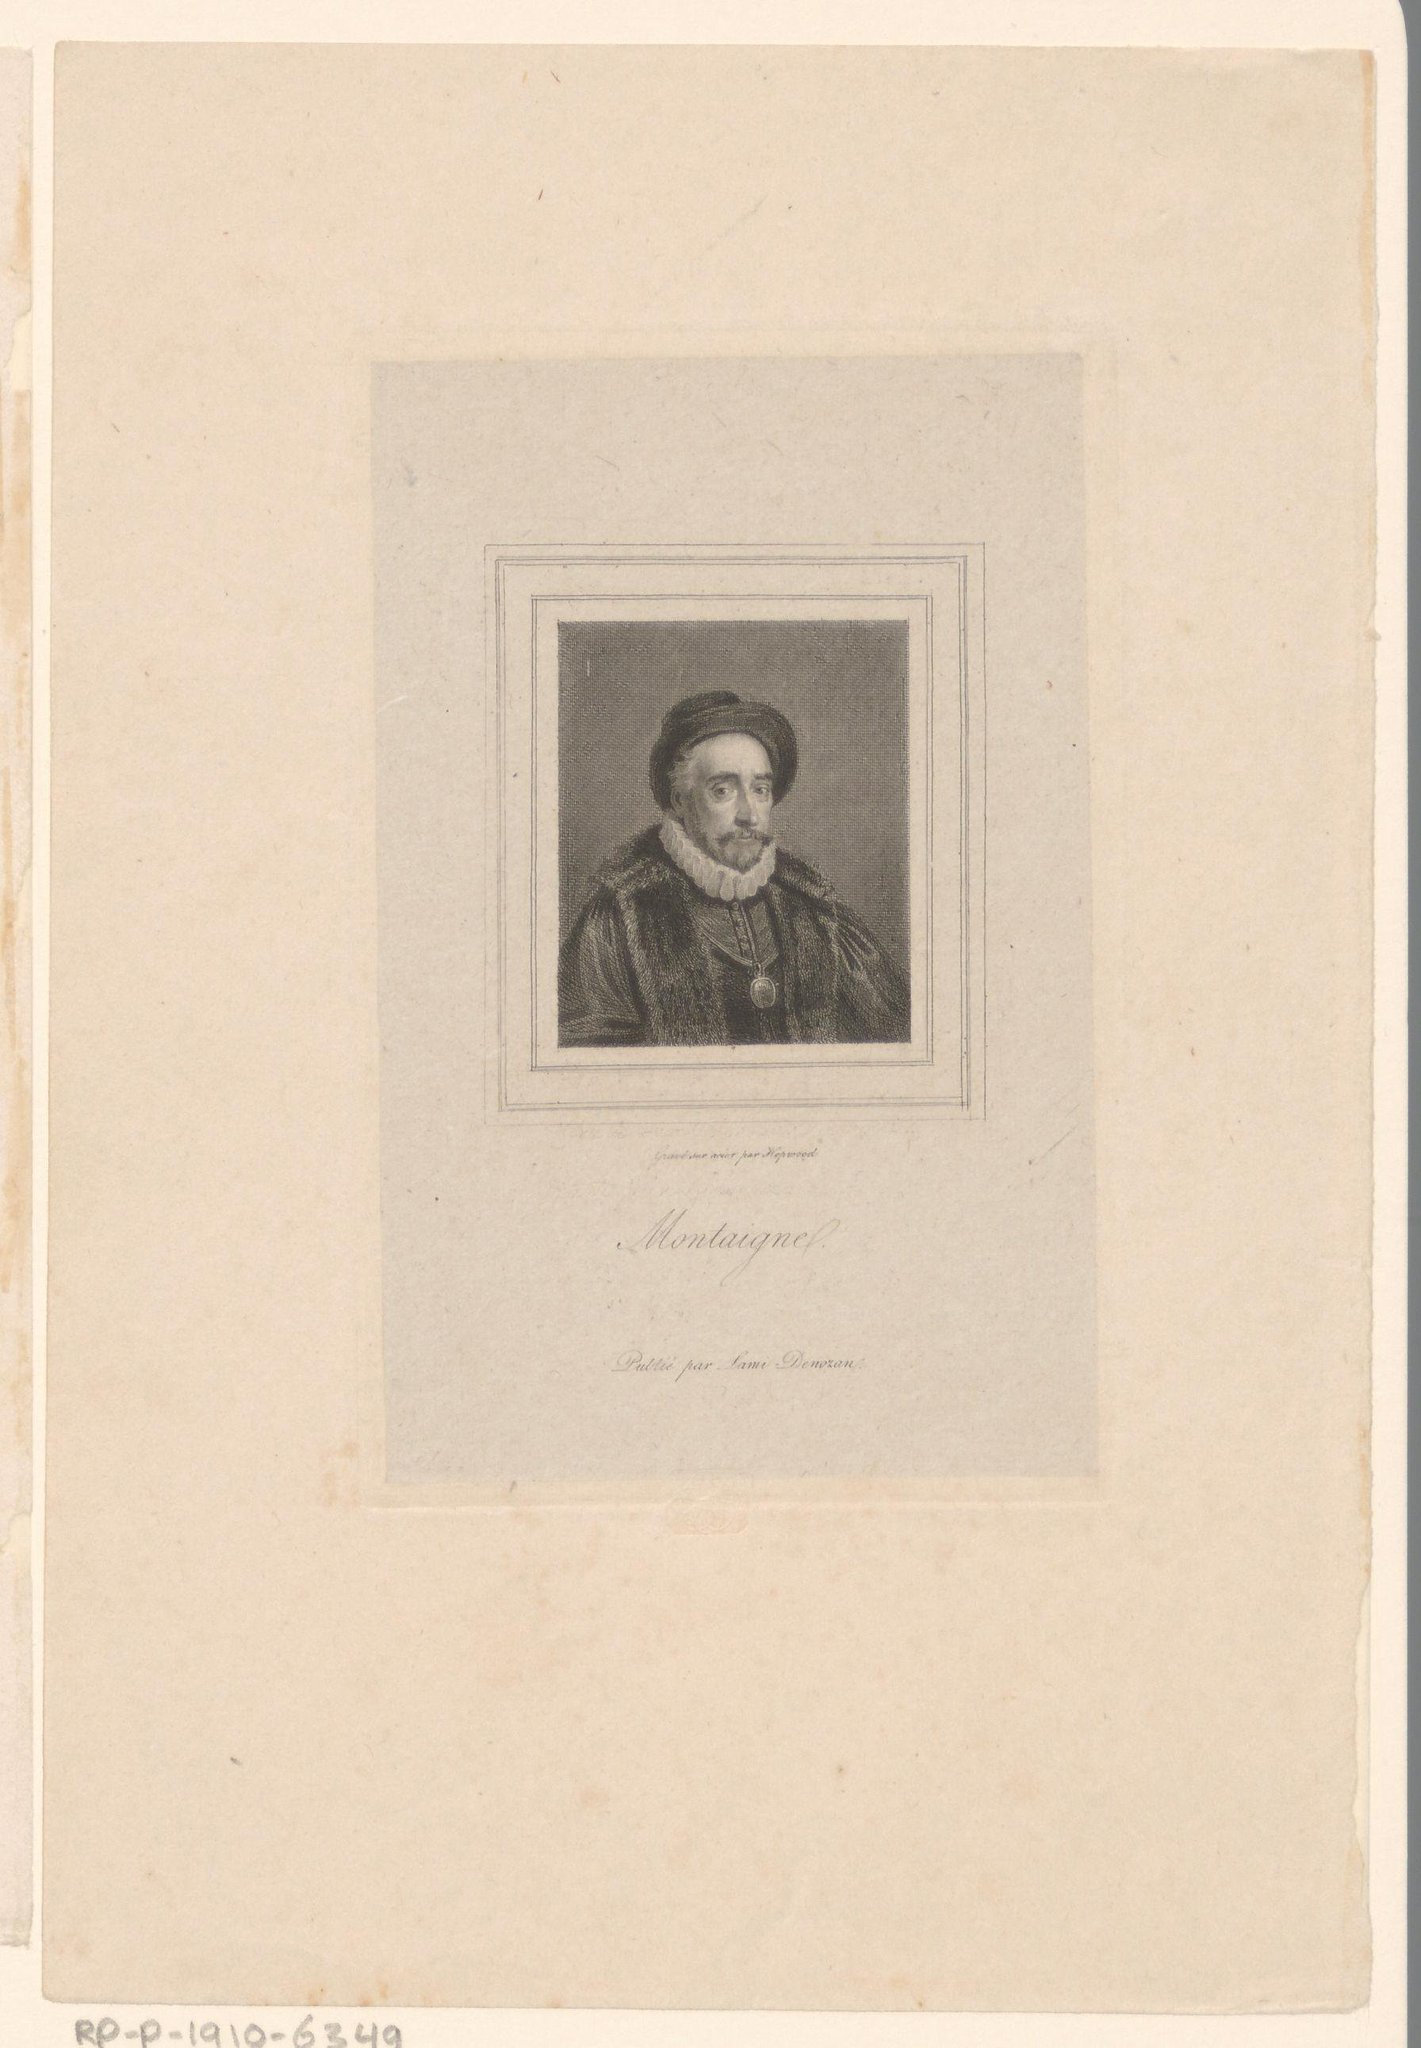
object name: print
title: Portret van Michel de Montaigne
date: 1828-1850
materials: paper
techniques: etching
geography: paris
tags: michel eyquem de montaigne, historical persons, scholar, philosopher (+ portrait of scholar, scientist)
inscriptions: collector's mark: Lugt 2228, check stamp: ‘A[?]’